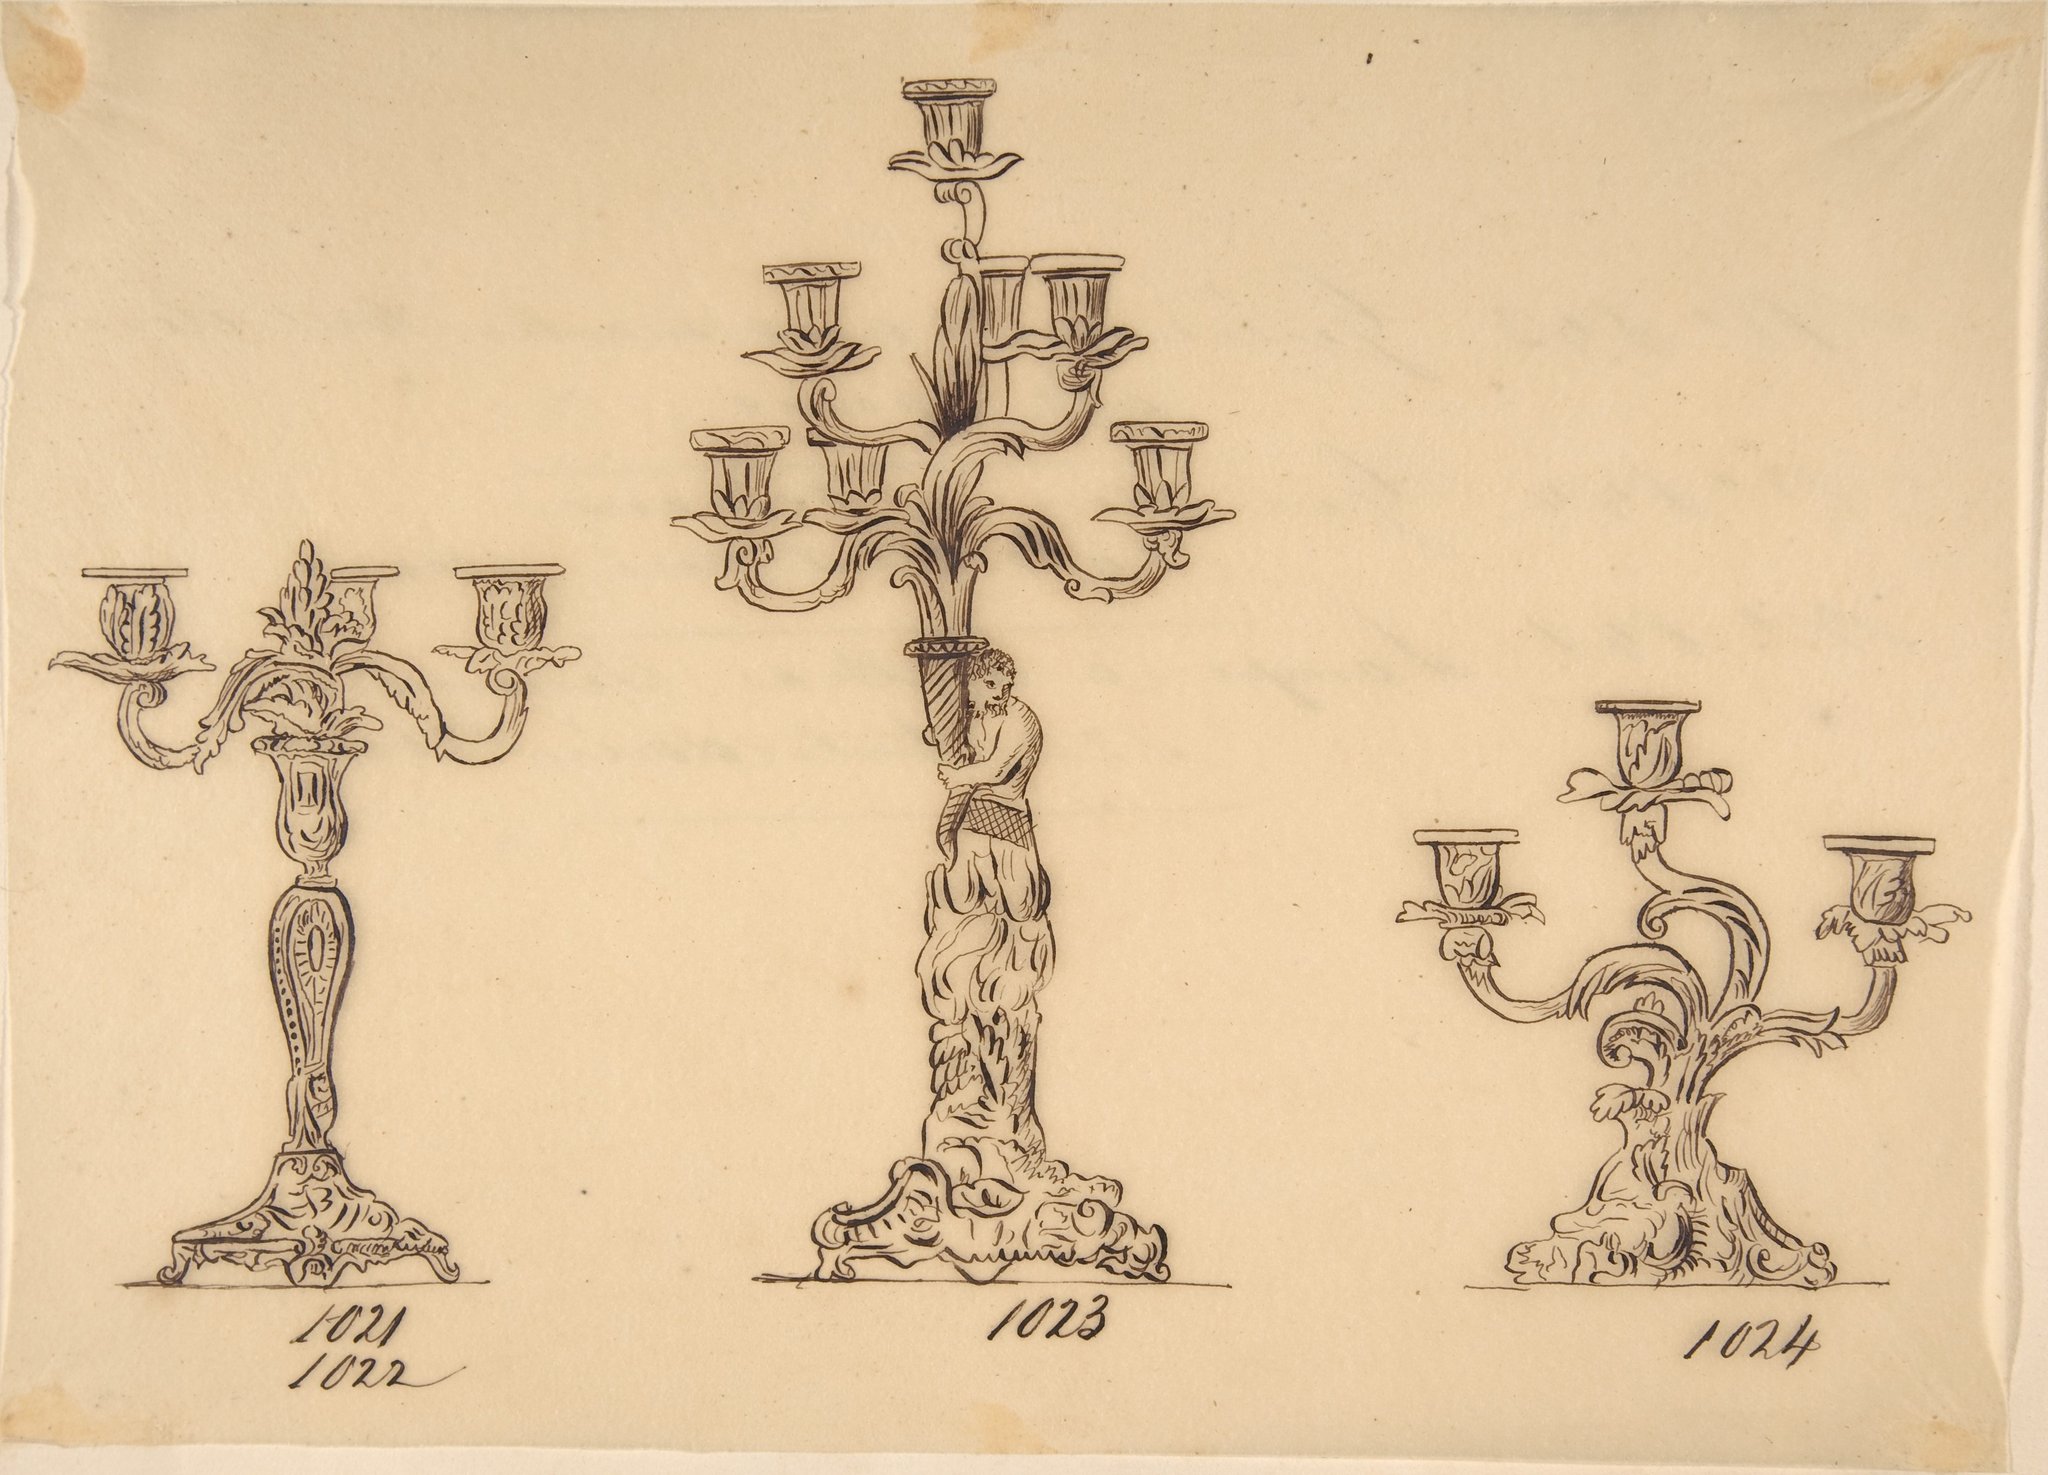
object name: drawing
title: Designs for Three Candelabras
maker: anonymous, french, 19th century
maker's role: artist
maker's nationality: french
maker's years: 1800-1900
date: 1801-1900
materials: ink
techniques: pen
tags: candelabra